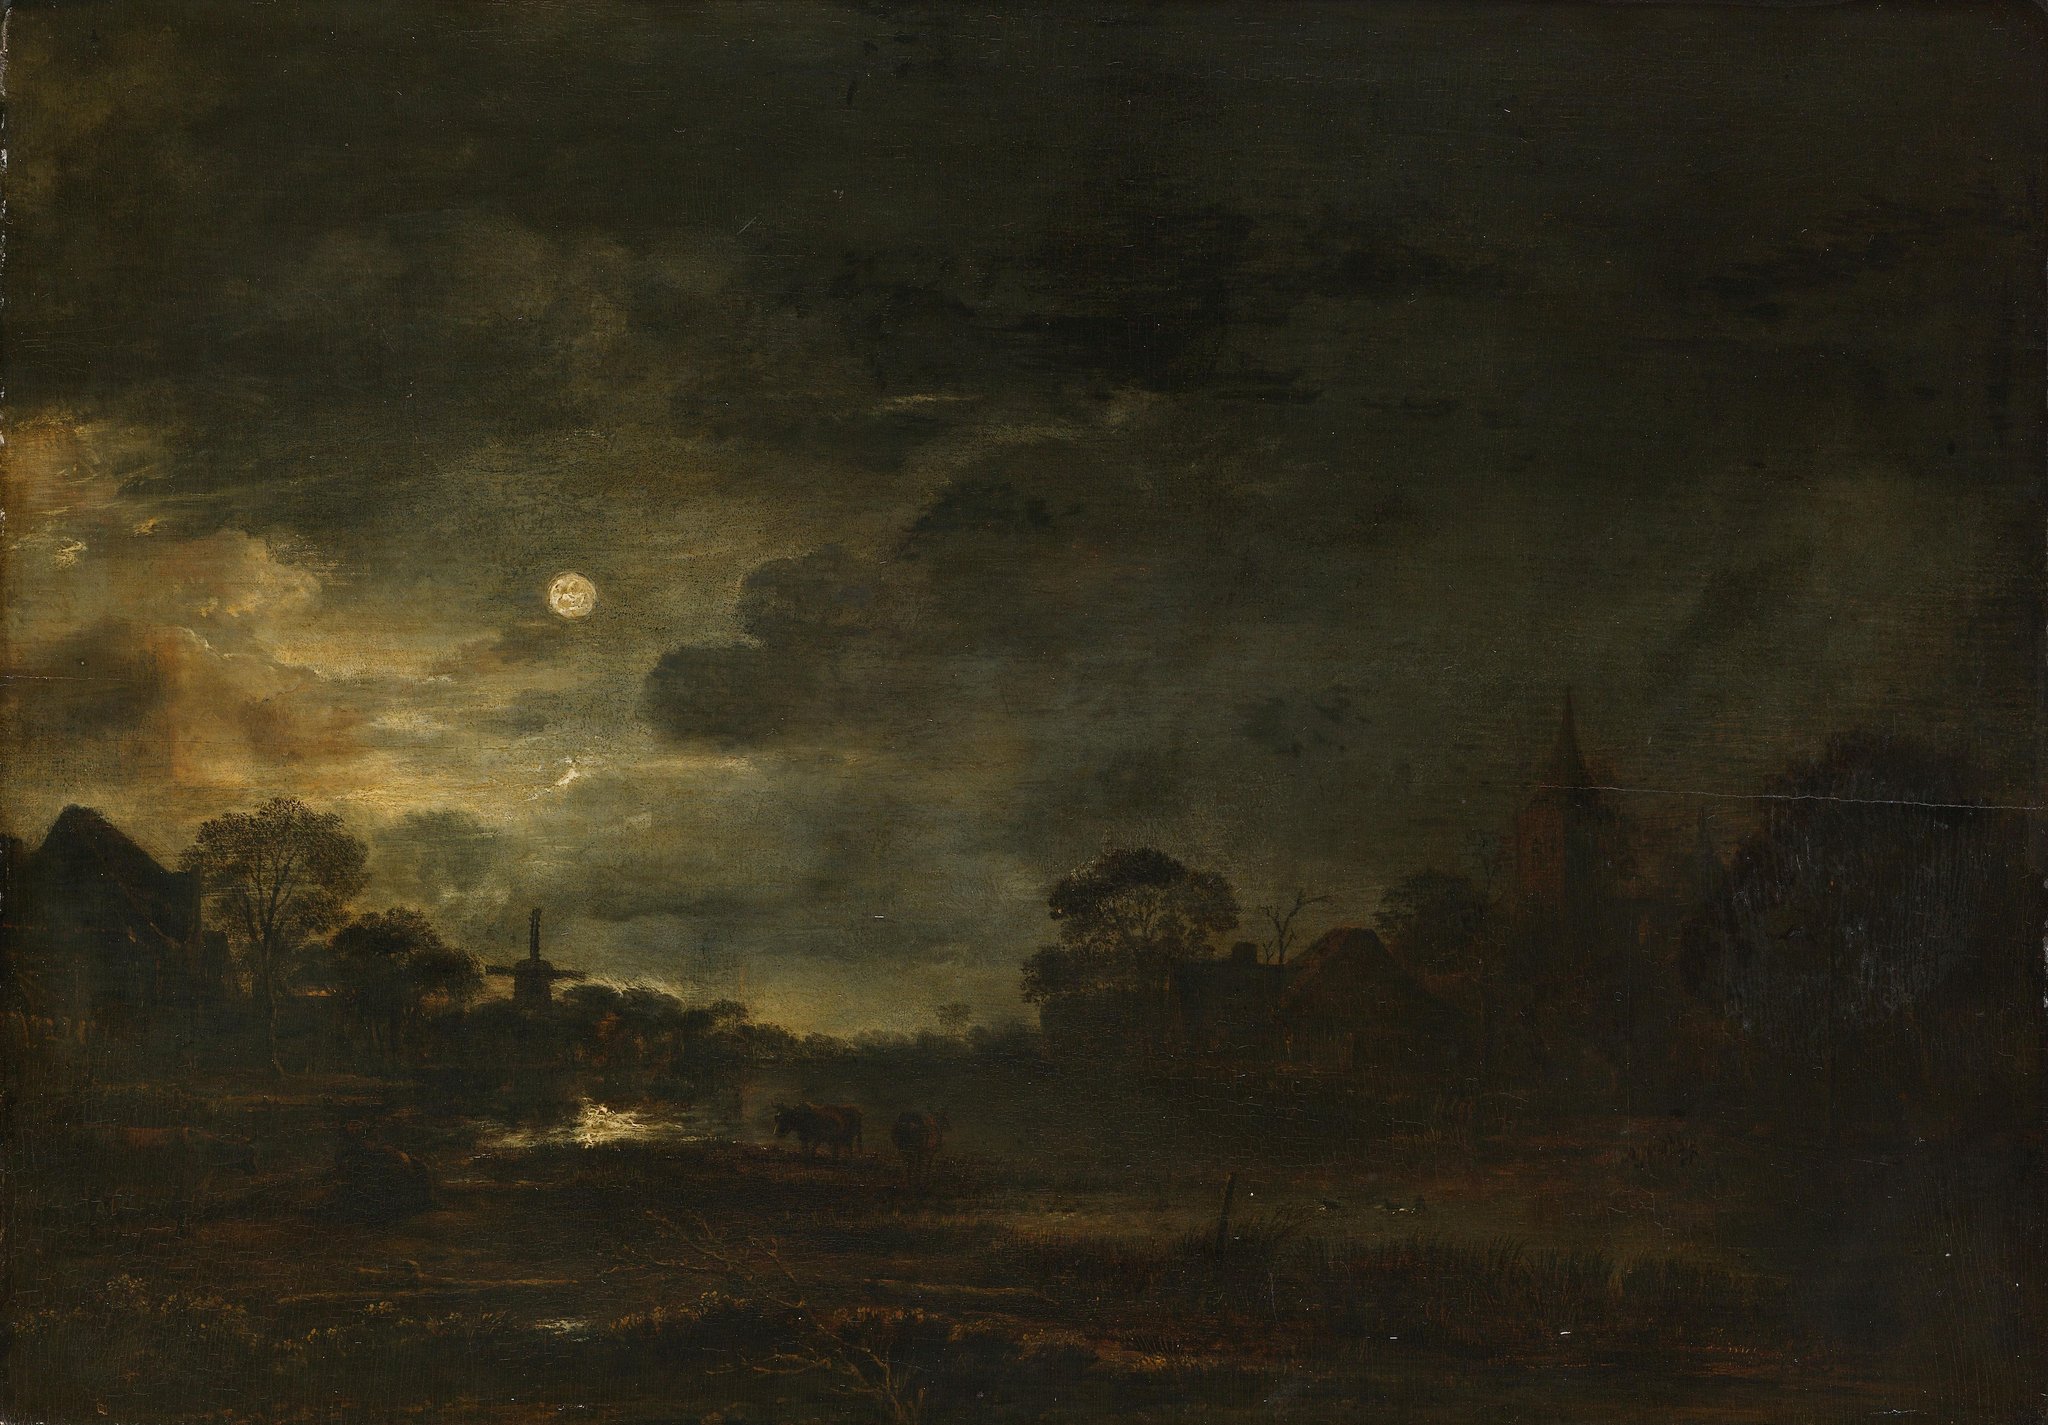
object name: painting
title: Landscape by Moonlight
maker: aert van der neer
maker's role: painter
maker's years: 1603-1677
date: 1640-1650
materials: oil, panel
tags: moonlight, windmill in landscape, night ~ landscape (sometimes titled 'nox')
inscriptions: signature, with monogram, bottom centre (AV ligated): ‘AV N’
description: Landschap bij maanlicht. Gezicht op een dorp aan het water. Aan de waterkant staan enkele koeien, rechts het dorp, links in de verte een molen. De maan schijnt door het wolkendek.